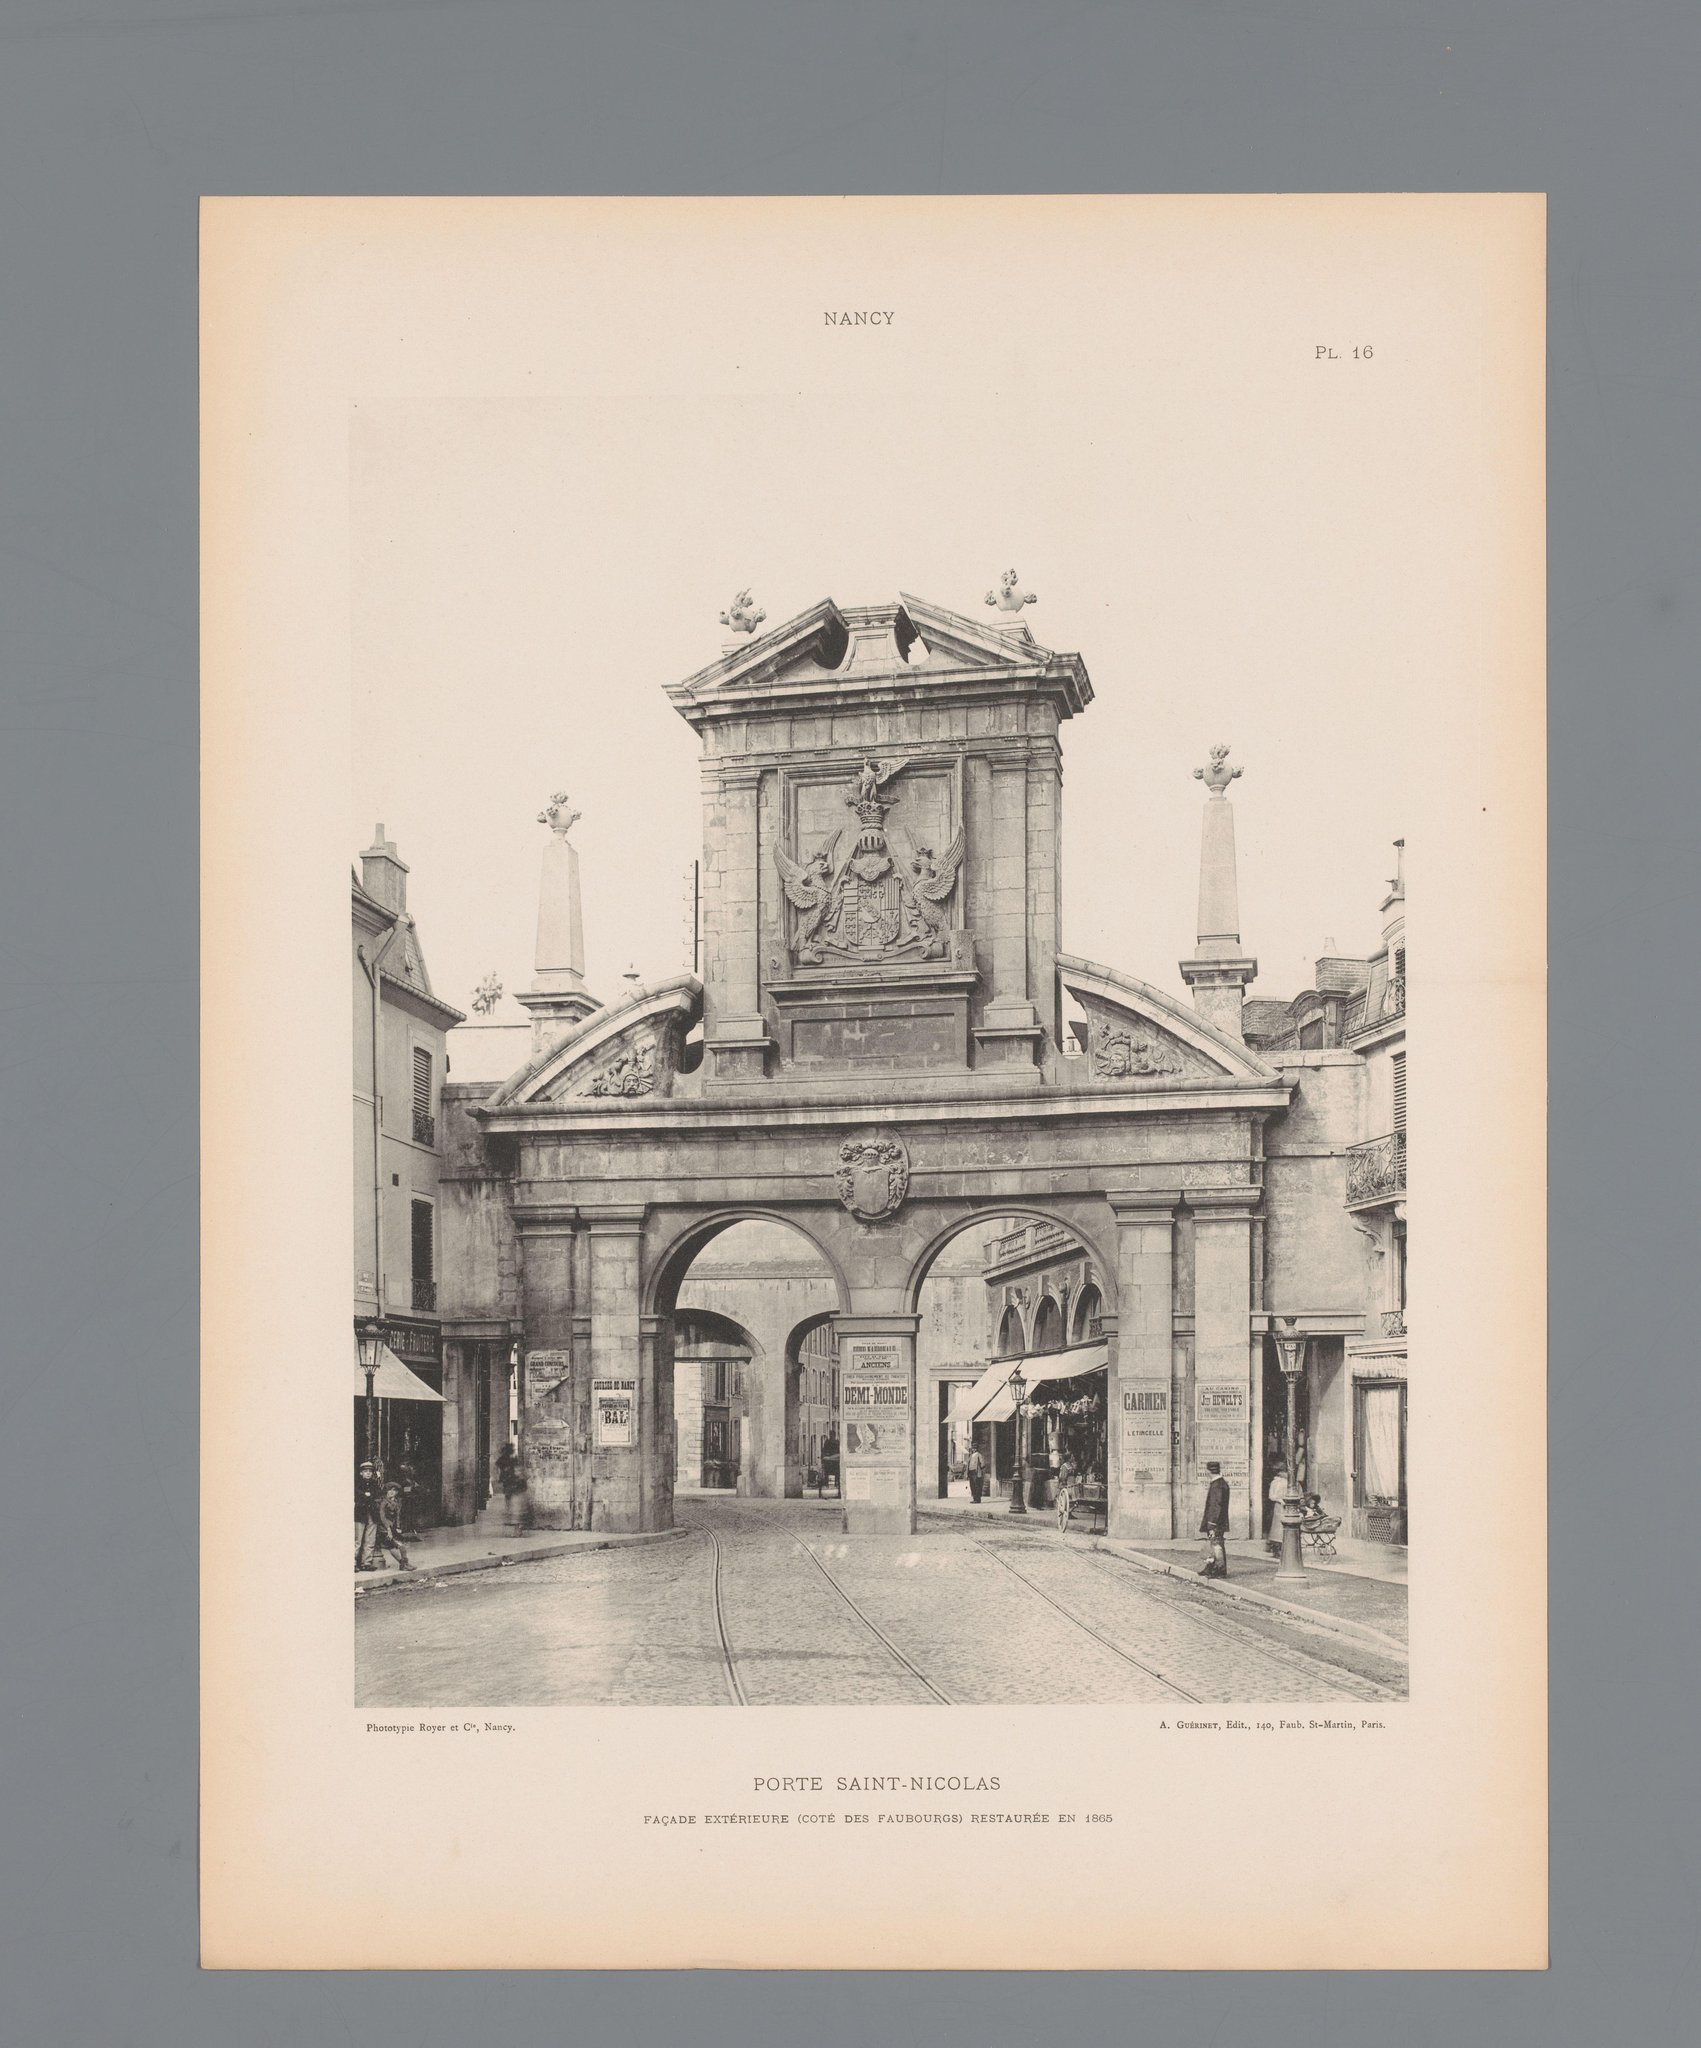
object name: photomechanical print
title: Gezicht op de Porte Saint-Nicolas te Nancy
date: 1891-1896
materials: paper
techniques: photograph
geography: paris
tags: city-gate (+ city(-scape) with figures, staffage)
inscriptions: inscription: ‘Porte Saint-Nicolas (...)’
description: Deze prent maakt deel uit van een omslag met 103 prenten op 101 bladen en een titelblad.